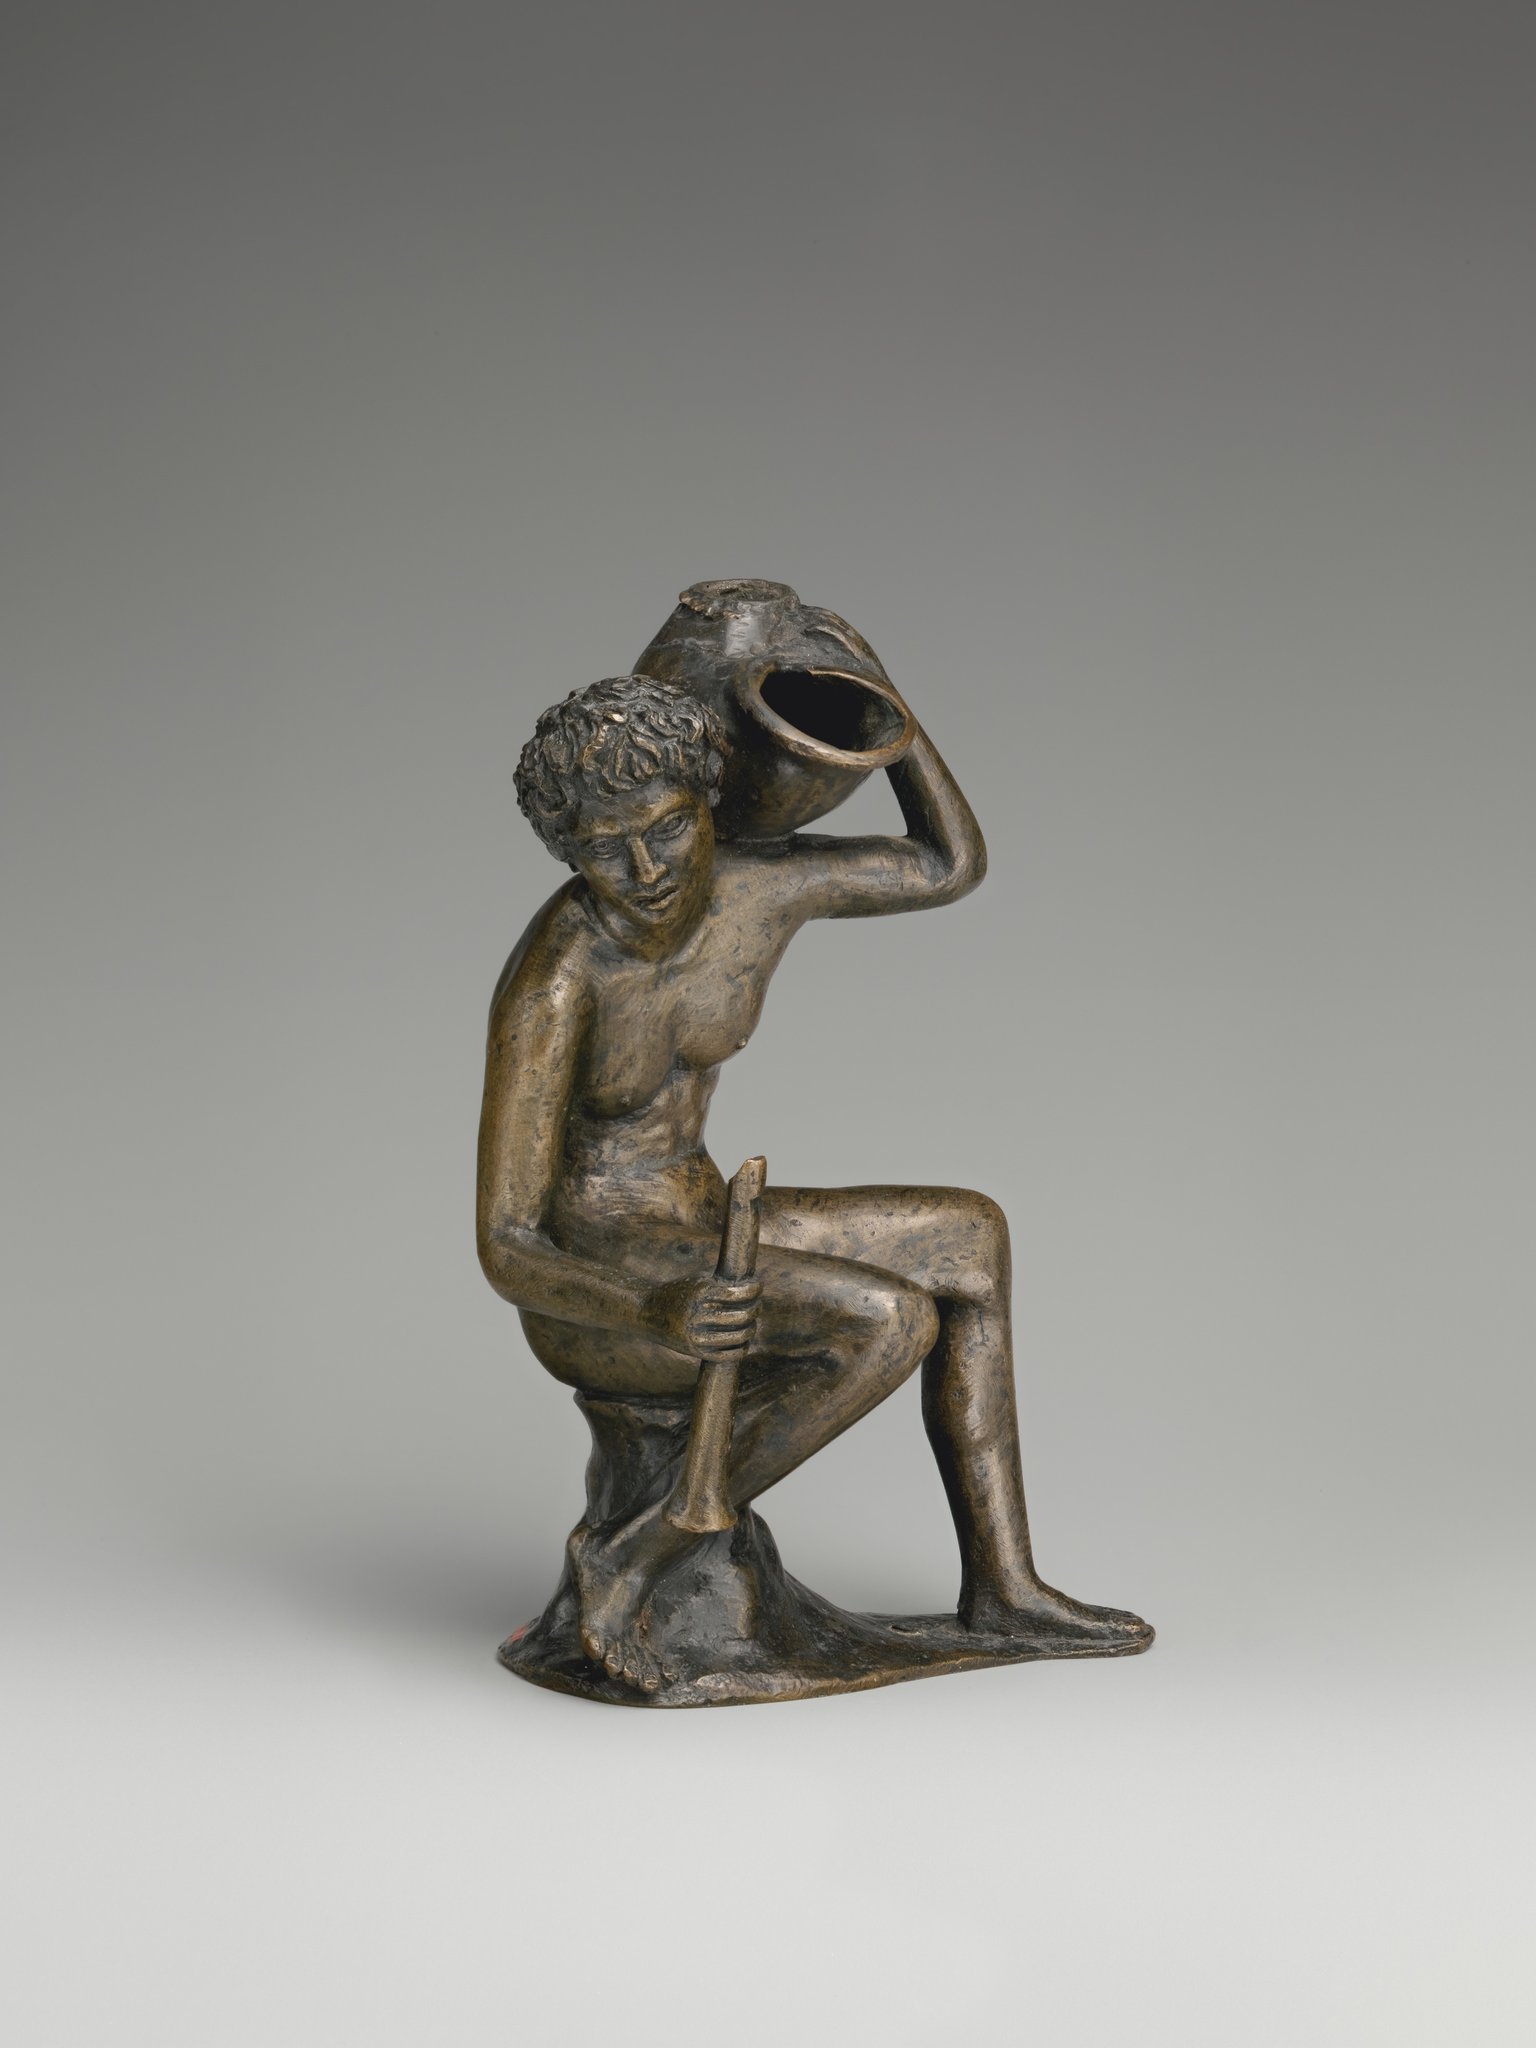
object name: lamp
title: Seated youth with a lamp in the form of a snail shell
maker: andrea briosco, called riccio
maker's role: artist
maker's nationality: italian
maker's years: 1470-1532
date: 1567-1633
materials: bronze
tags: male nudes,trumpets